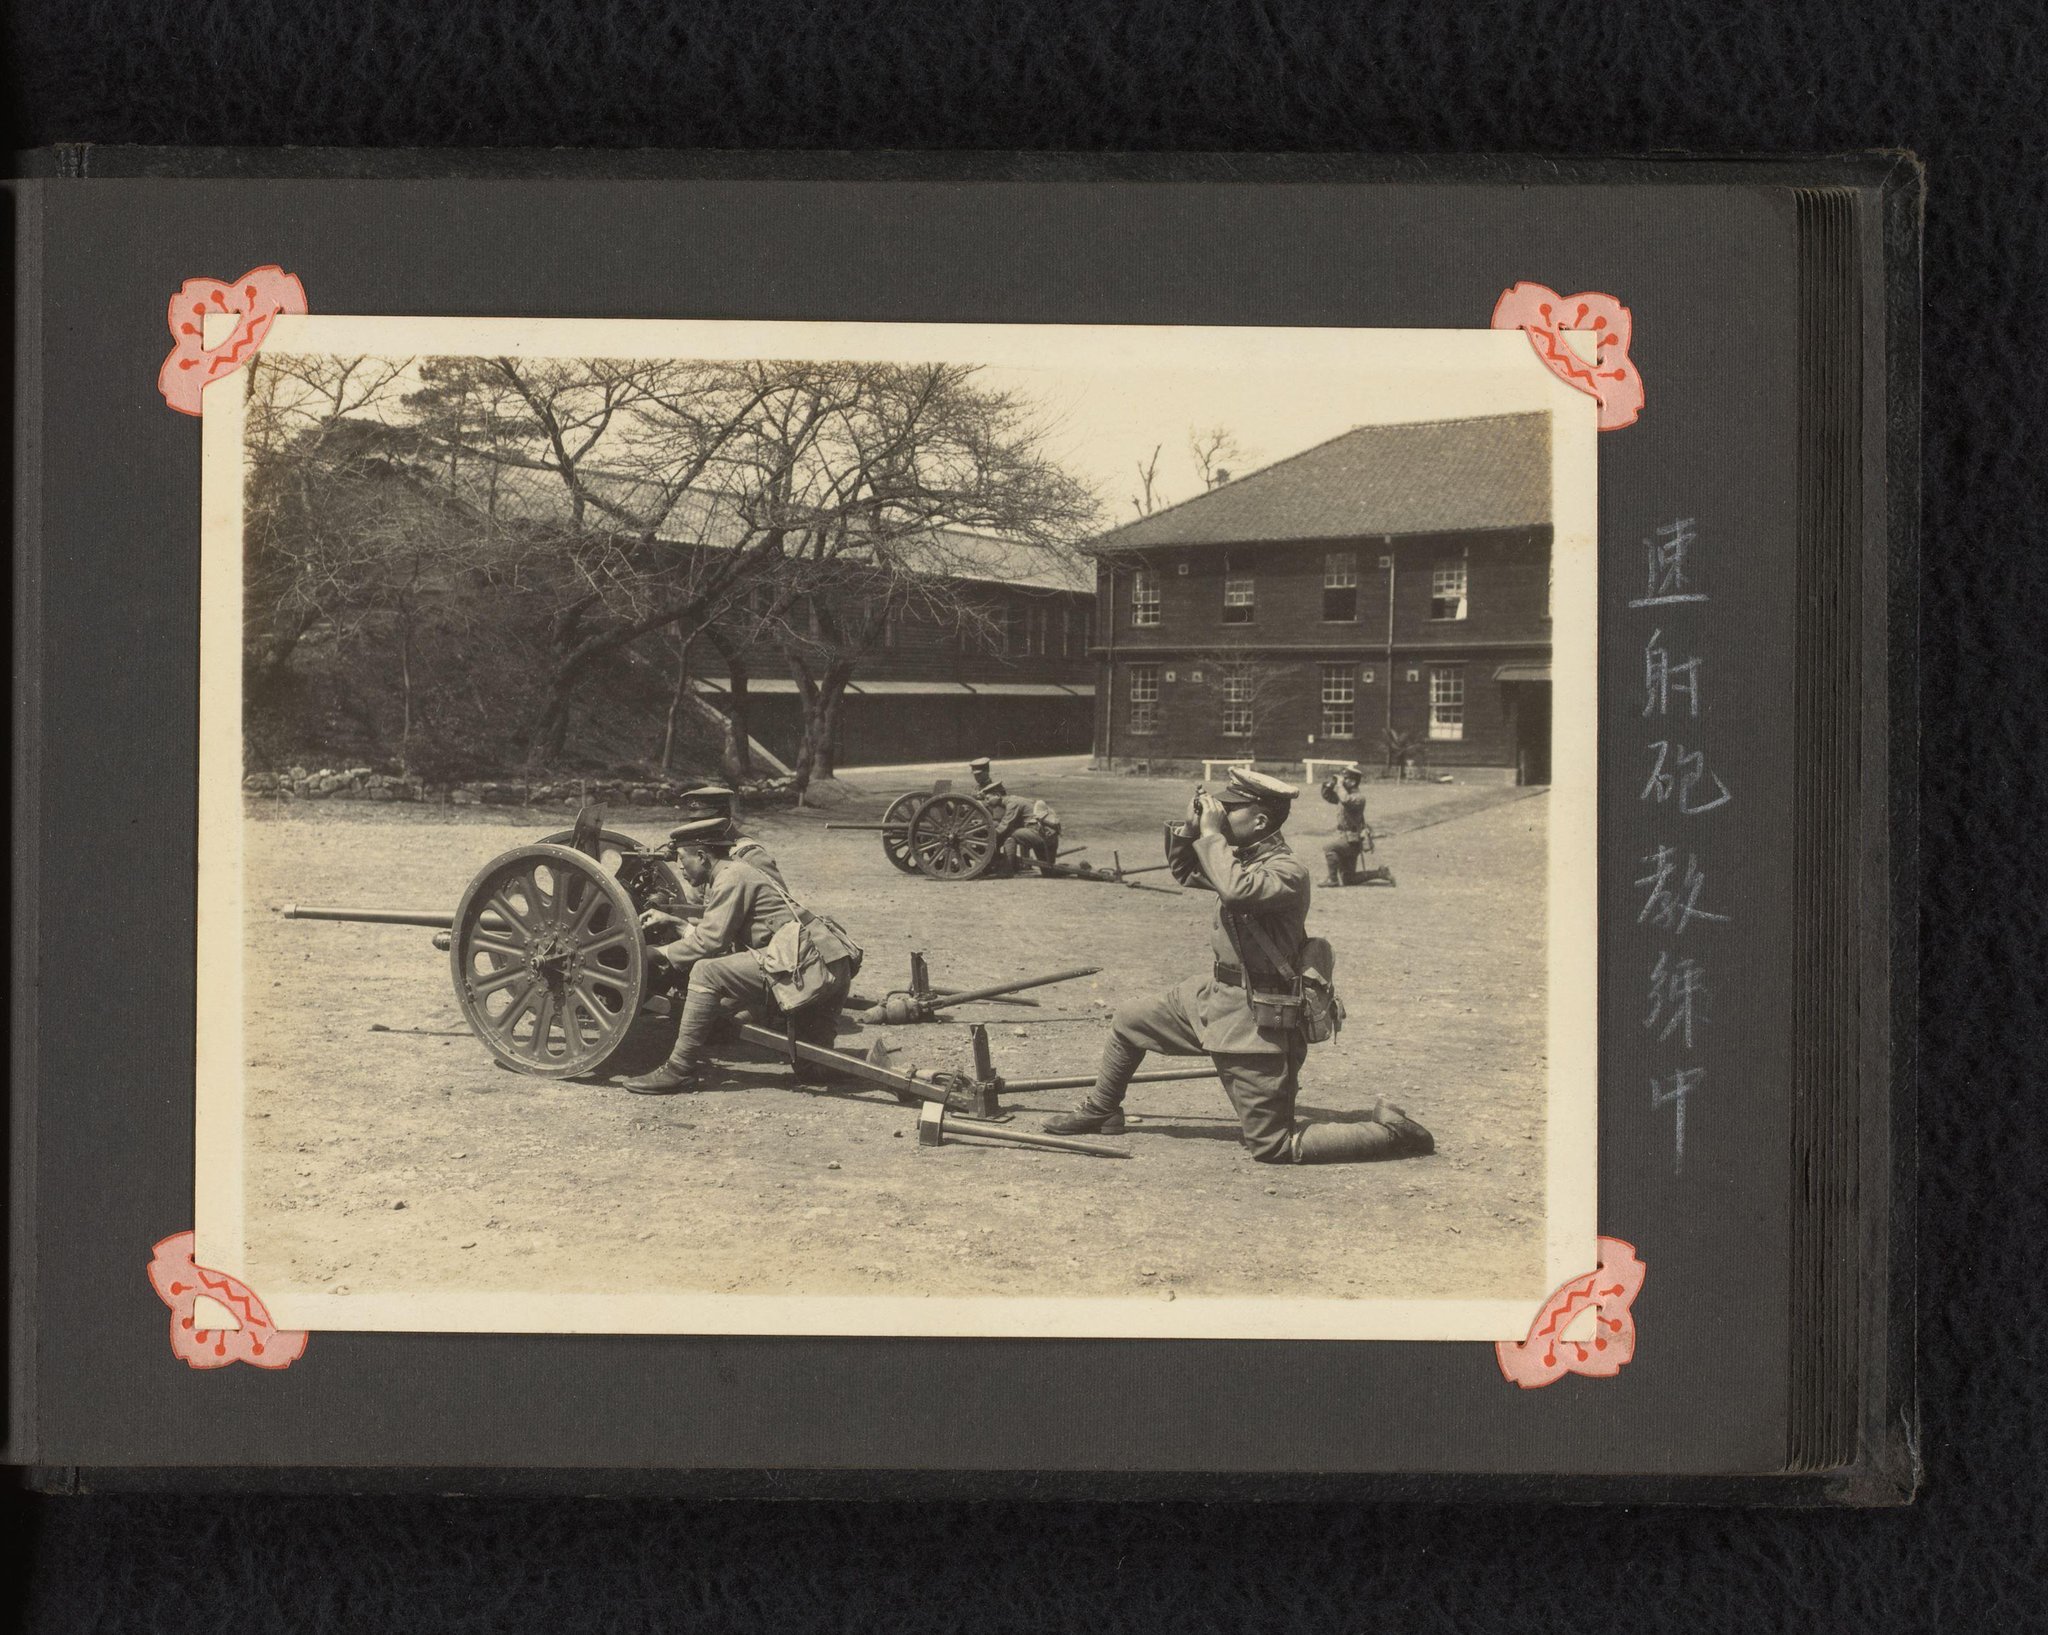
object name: photograph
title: Japanse soldaten met militair geschut, vermoedelijk bij een legerbasis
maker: Anonymous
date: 1937-1941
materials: paper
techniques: gelatin silver print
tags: the soldier; the soldier's life, projectiles, explosives, etc.